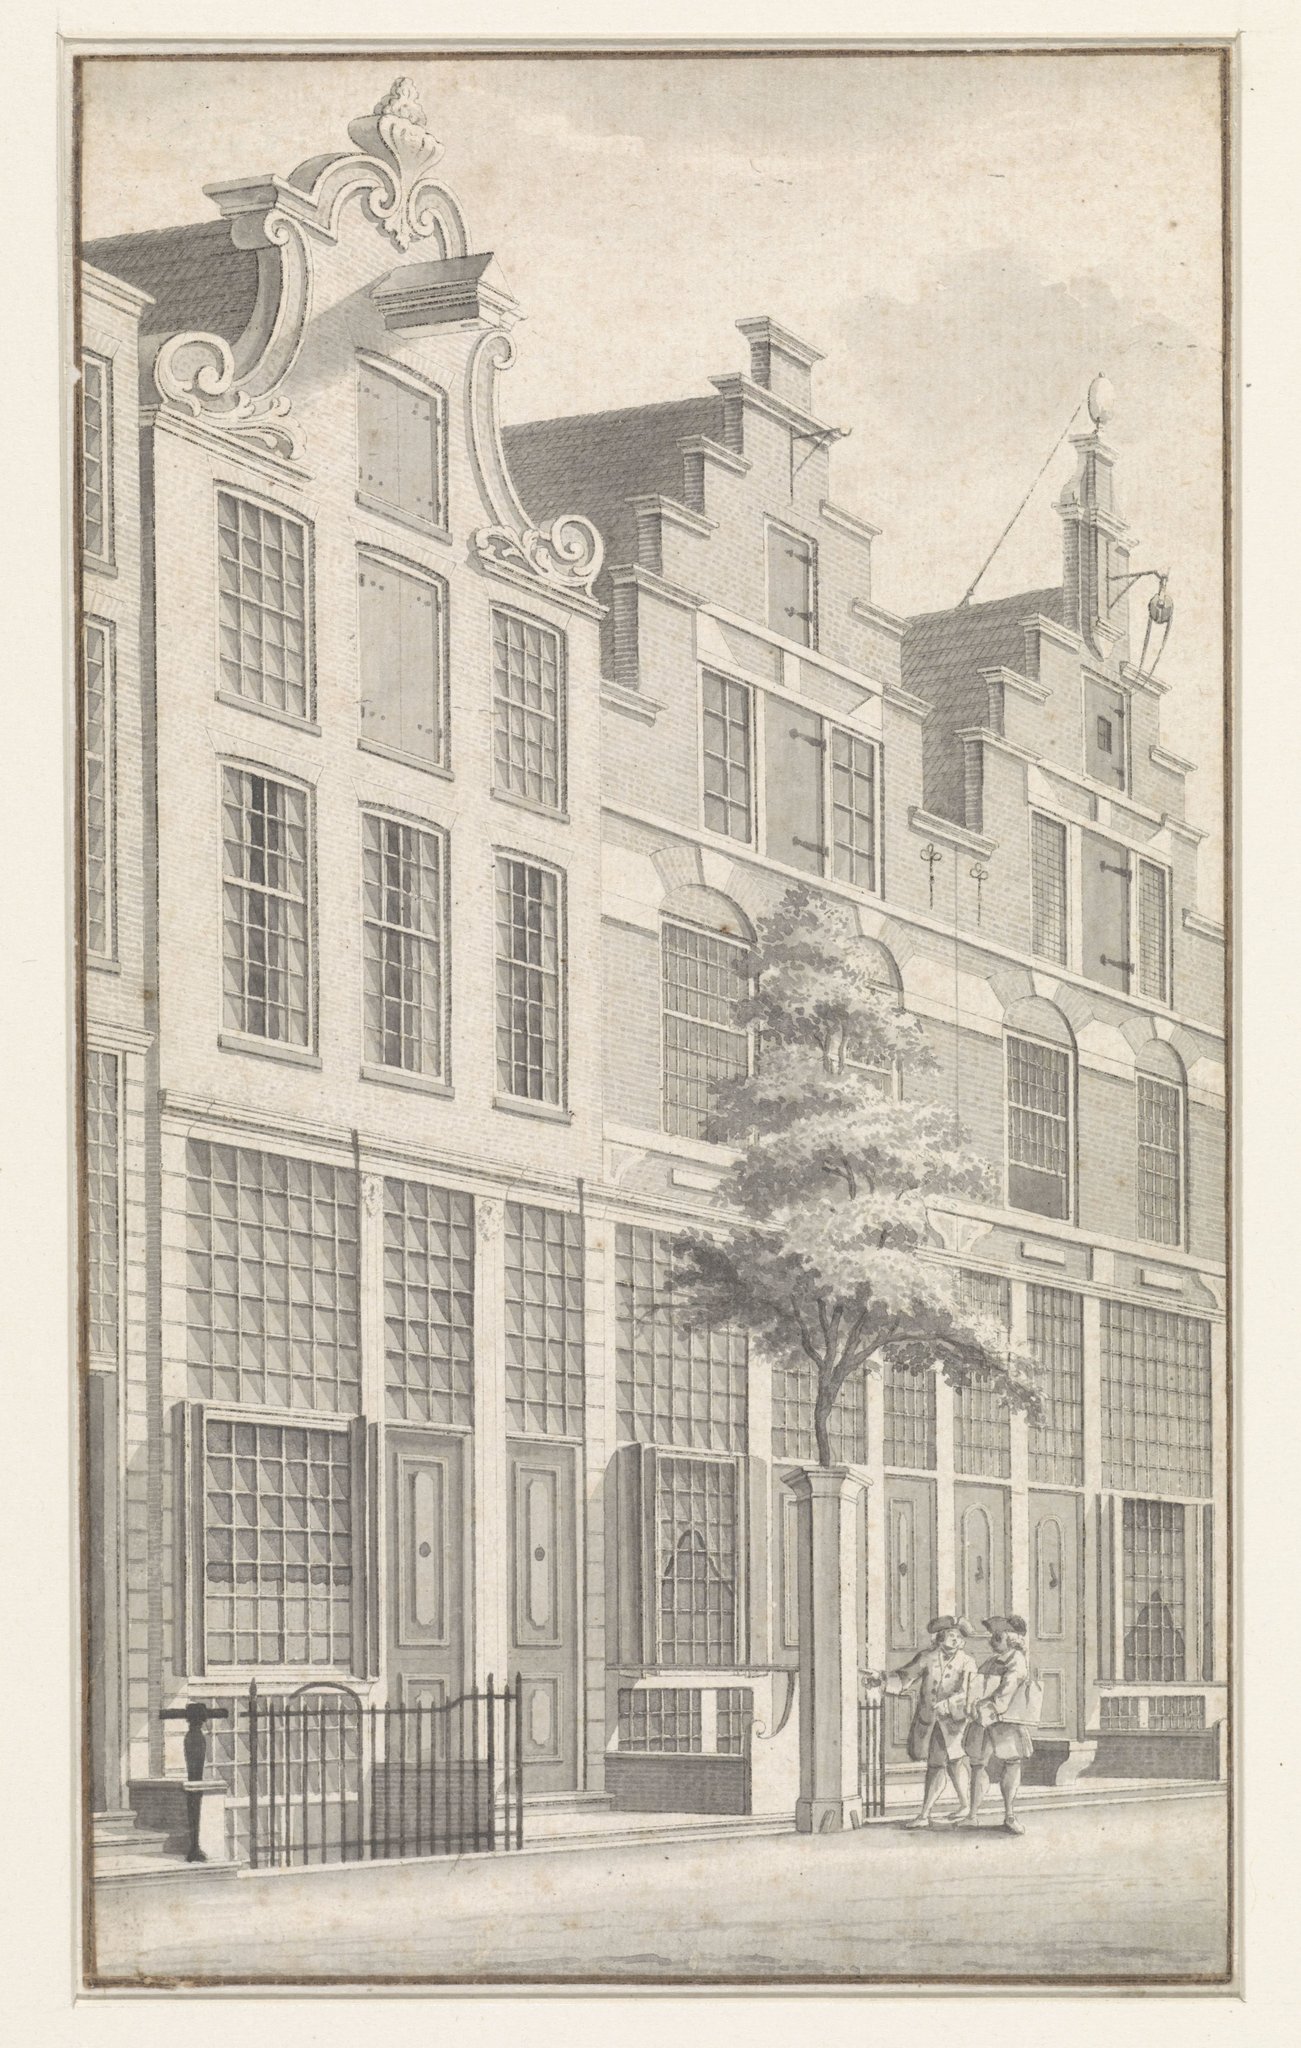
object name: print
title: Huis van Hendrik Busserus op de Haarlemmerdijk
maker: hendrik van hilten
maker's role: draughtsman, print maker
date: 1773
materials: paper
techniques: brush, etching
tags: urban housing, street